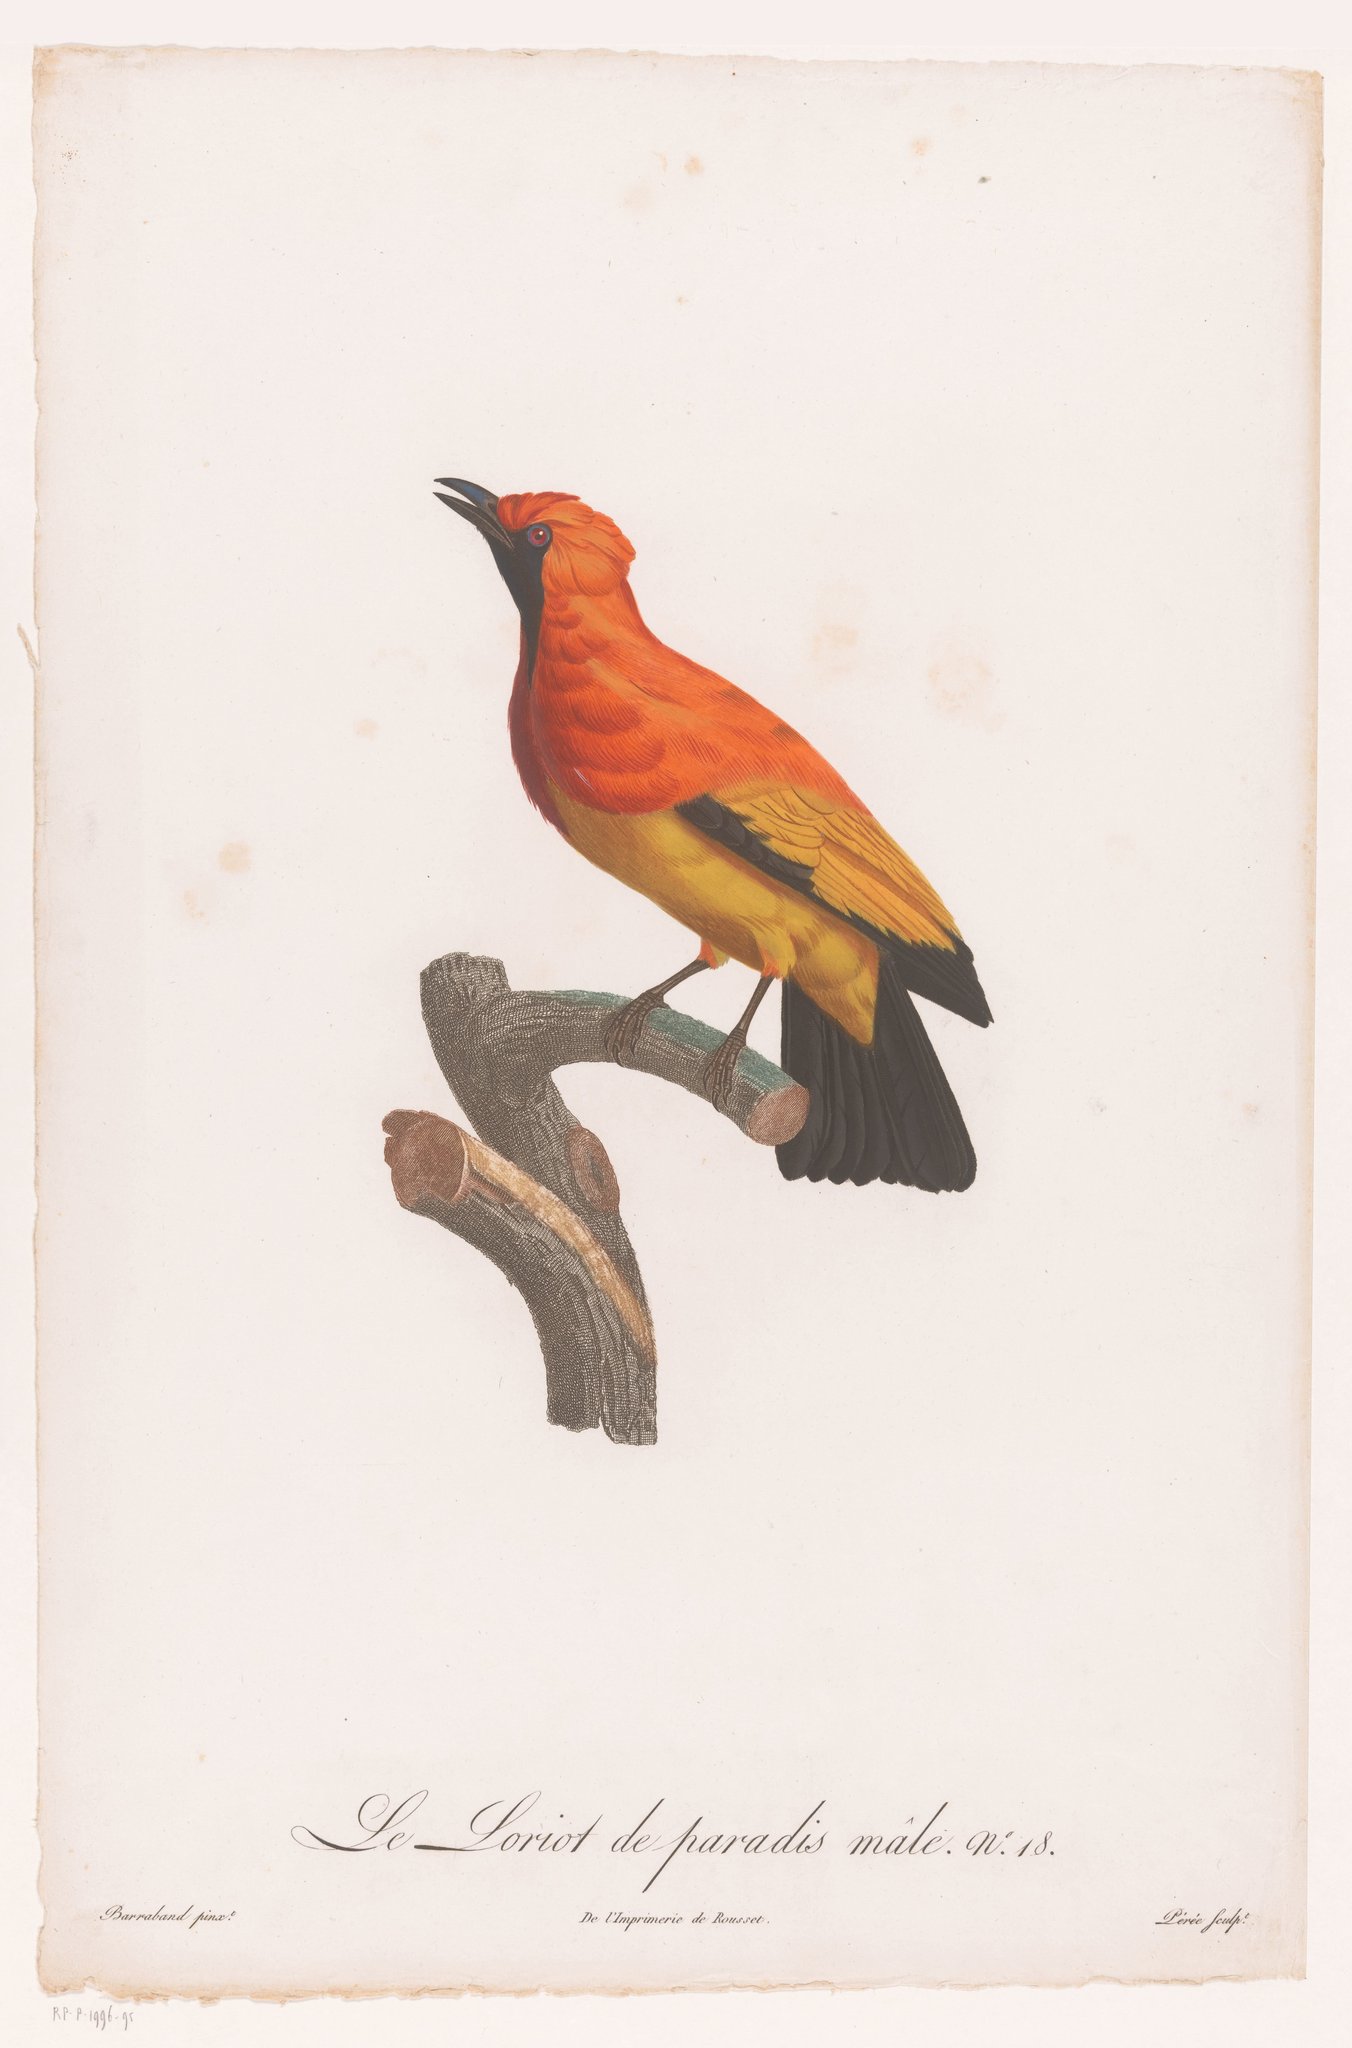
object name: book illustration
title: Le Loriot de paradis mâle No 18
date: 1801-1806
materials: paper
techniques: engraving, etching, hand coloring, lithography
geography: paris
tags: birds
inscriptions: collector's mark: Lugt 2760, collector's mark: Lugt 2228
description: De mannelijke Paradijswielewaal, zittend op een tak, naar links. In oranje en geel. De vogel is door Linnaeus beschreven als een soort Wielewaal, maar blijkt, volgens de huidige inzichten, een Goudgele Masker-prieelvogel te zijn.